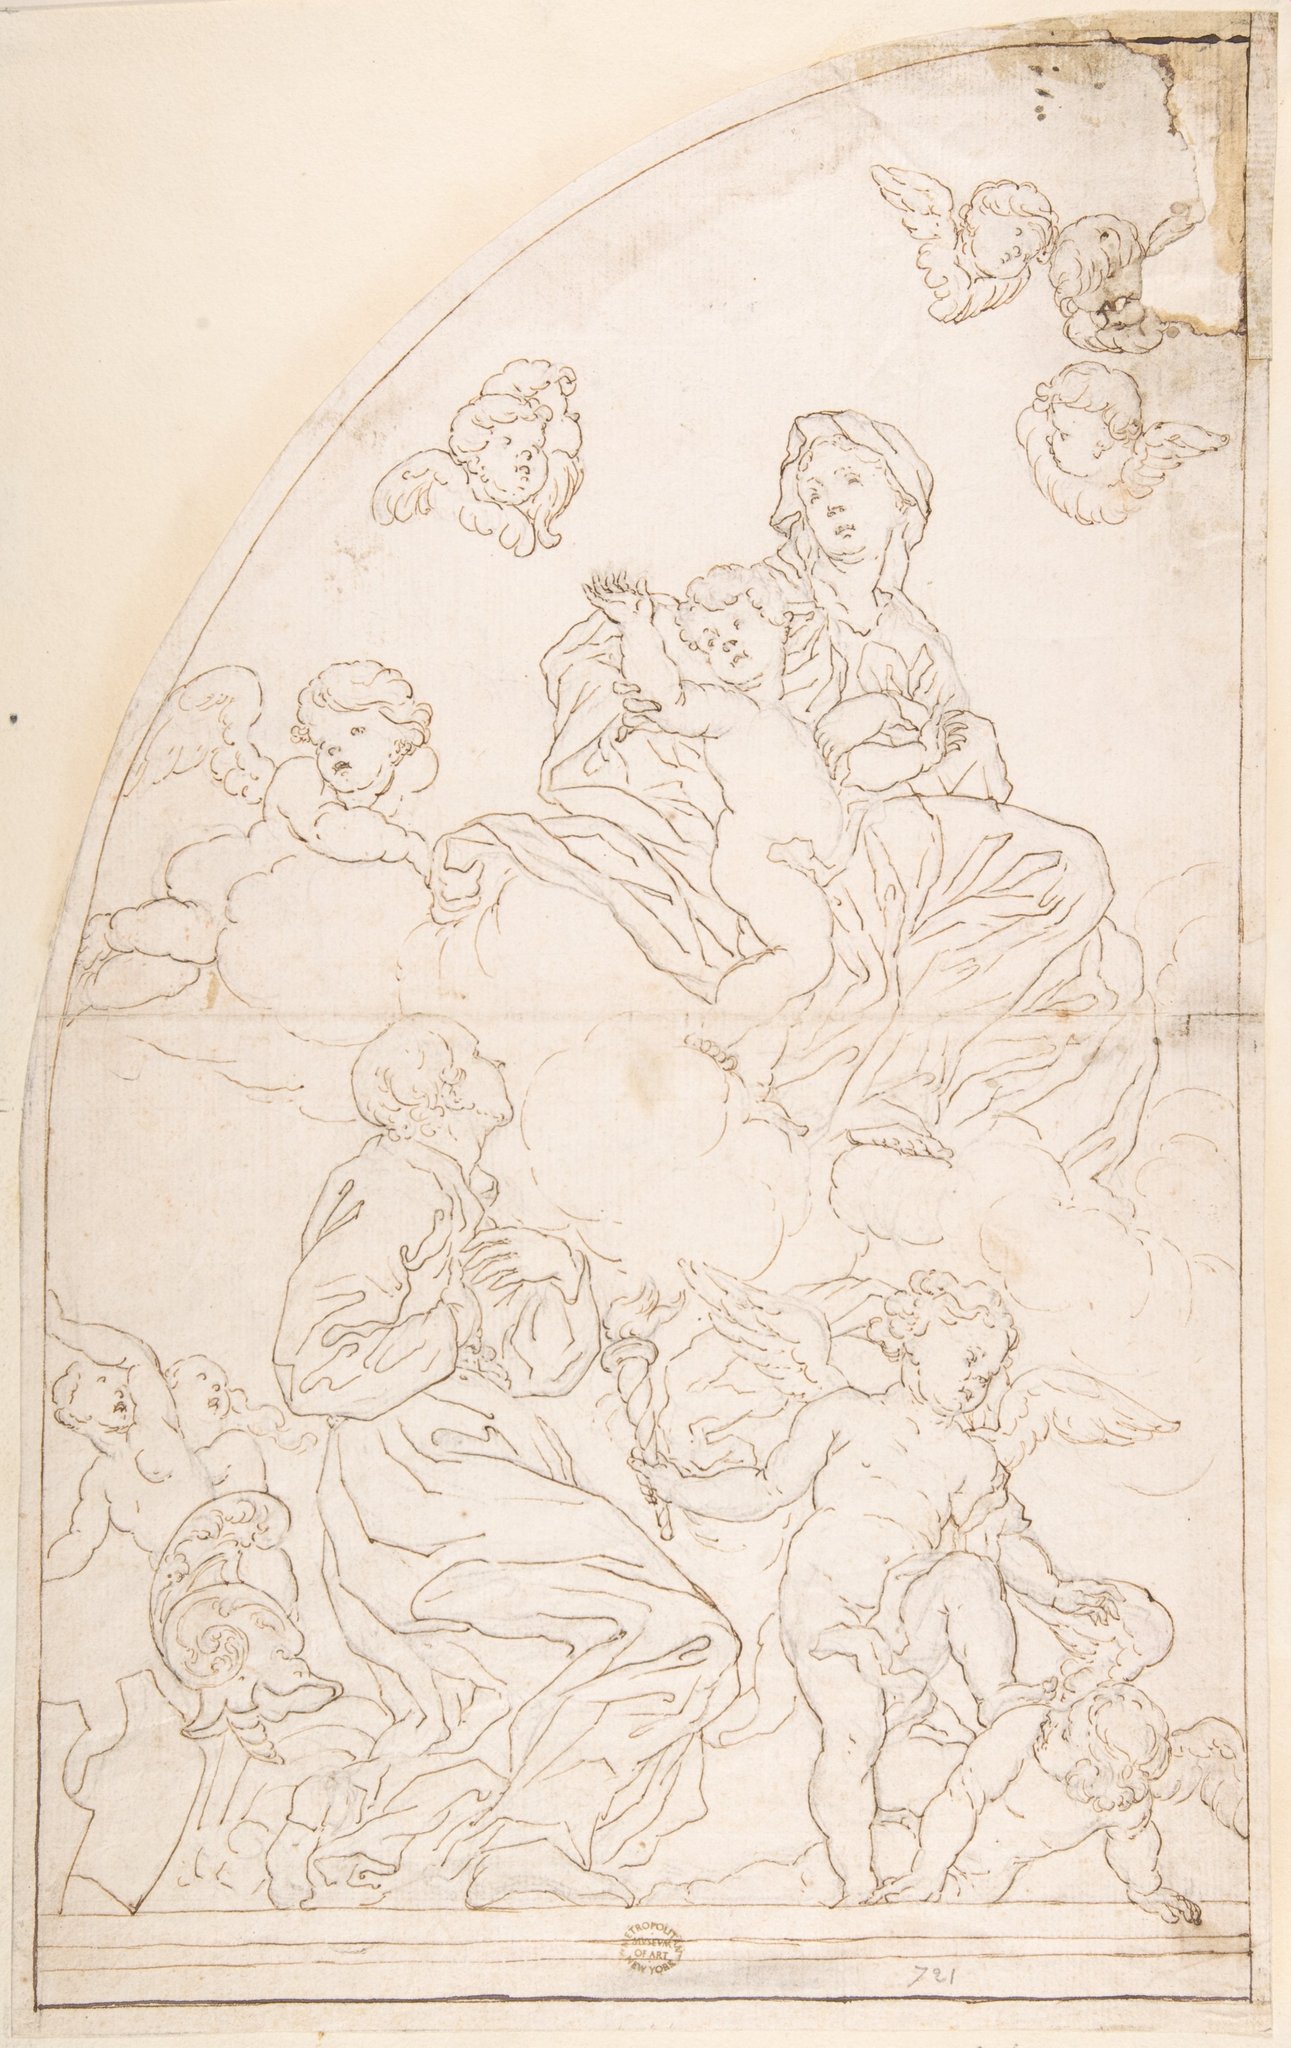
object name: drawing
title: Saint Adoring the Madonna and Child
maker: anonymous, italian, roman-bolognese, 17th century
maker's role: artist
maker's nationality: italian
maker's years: 1600-1700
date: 1601-1700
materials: chalk, ink, paper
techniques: drawing, pen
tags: angels,madonna and child,saints